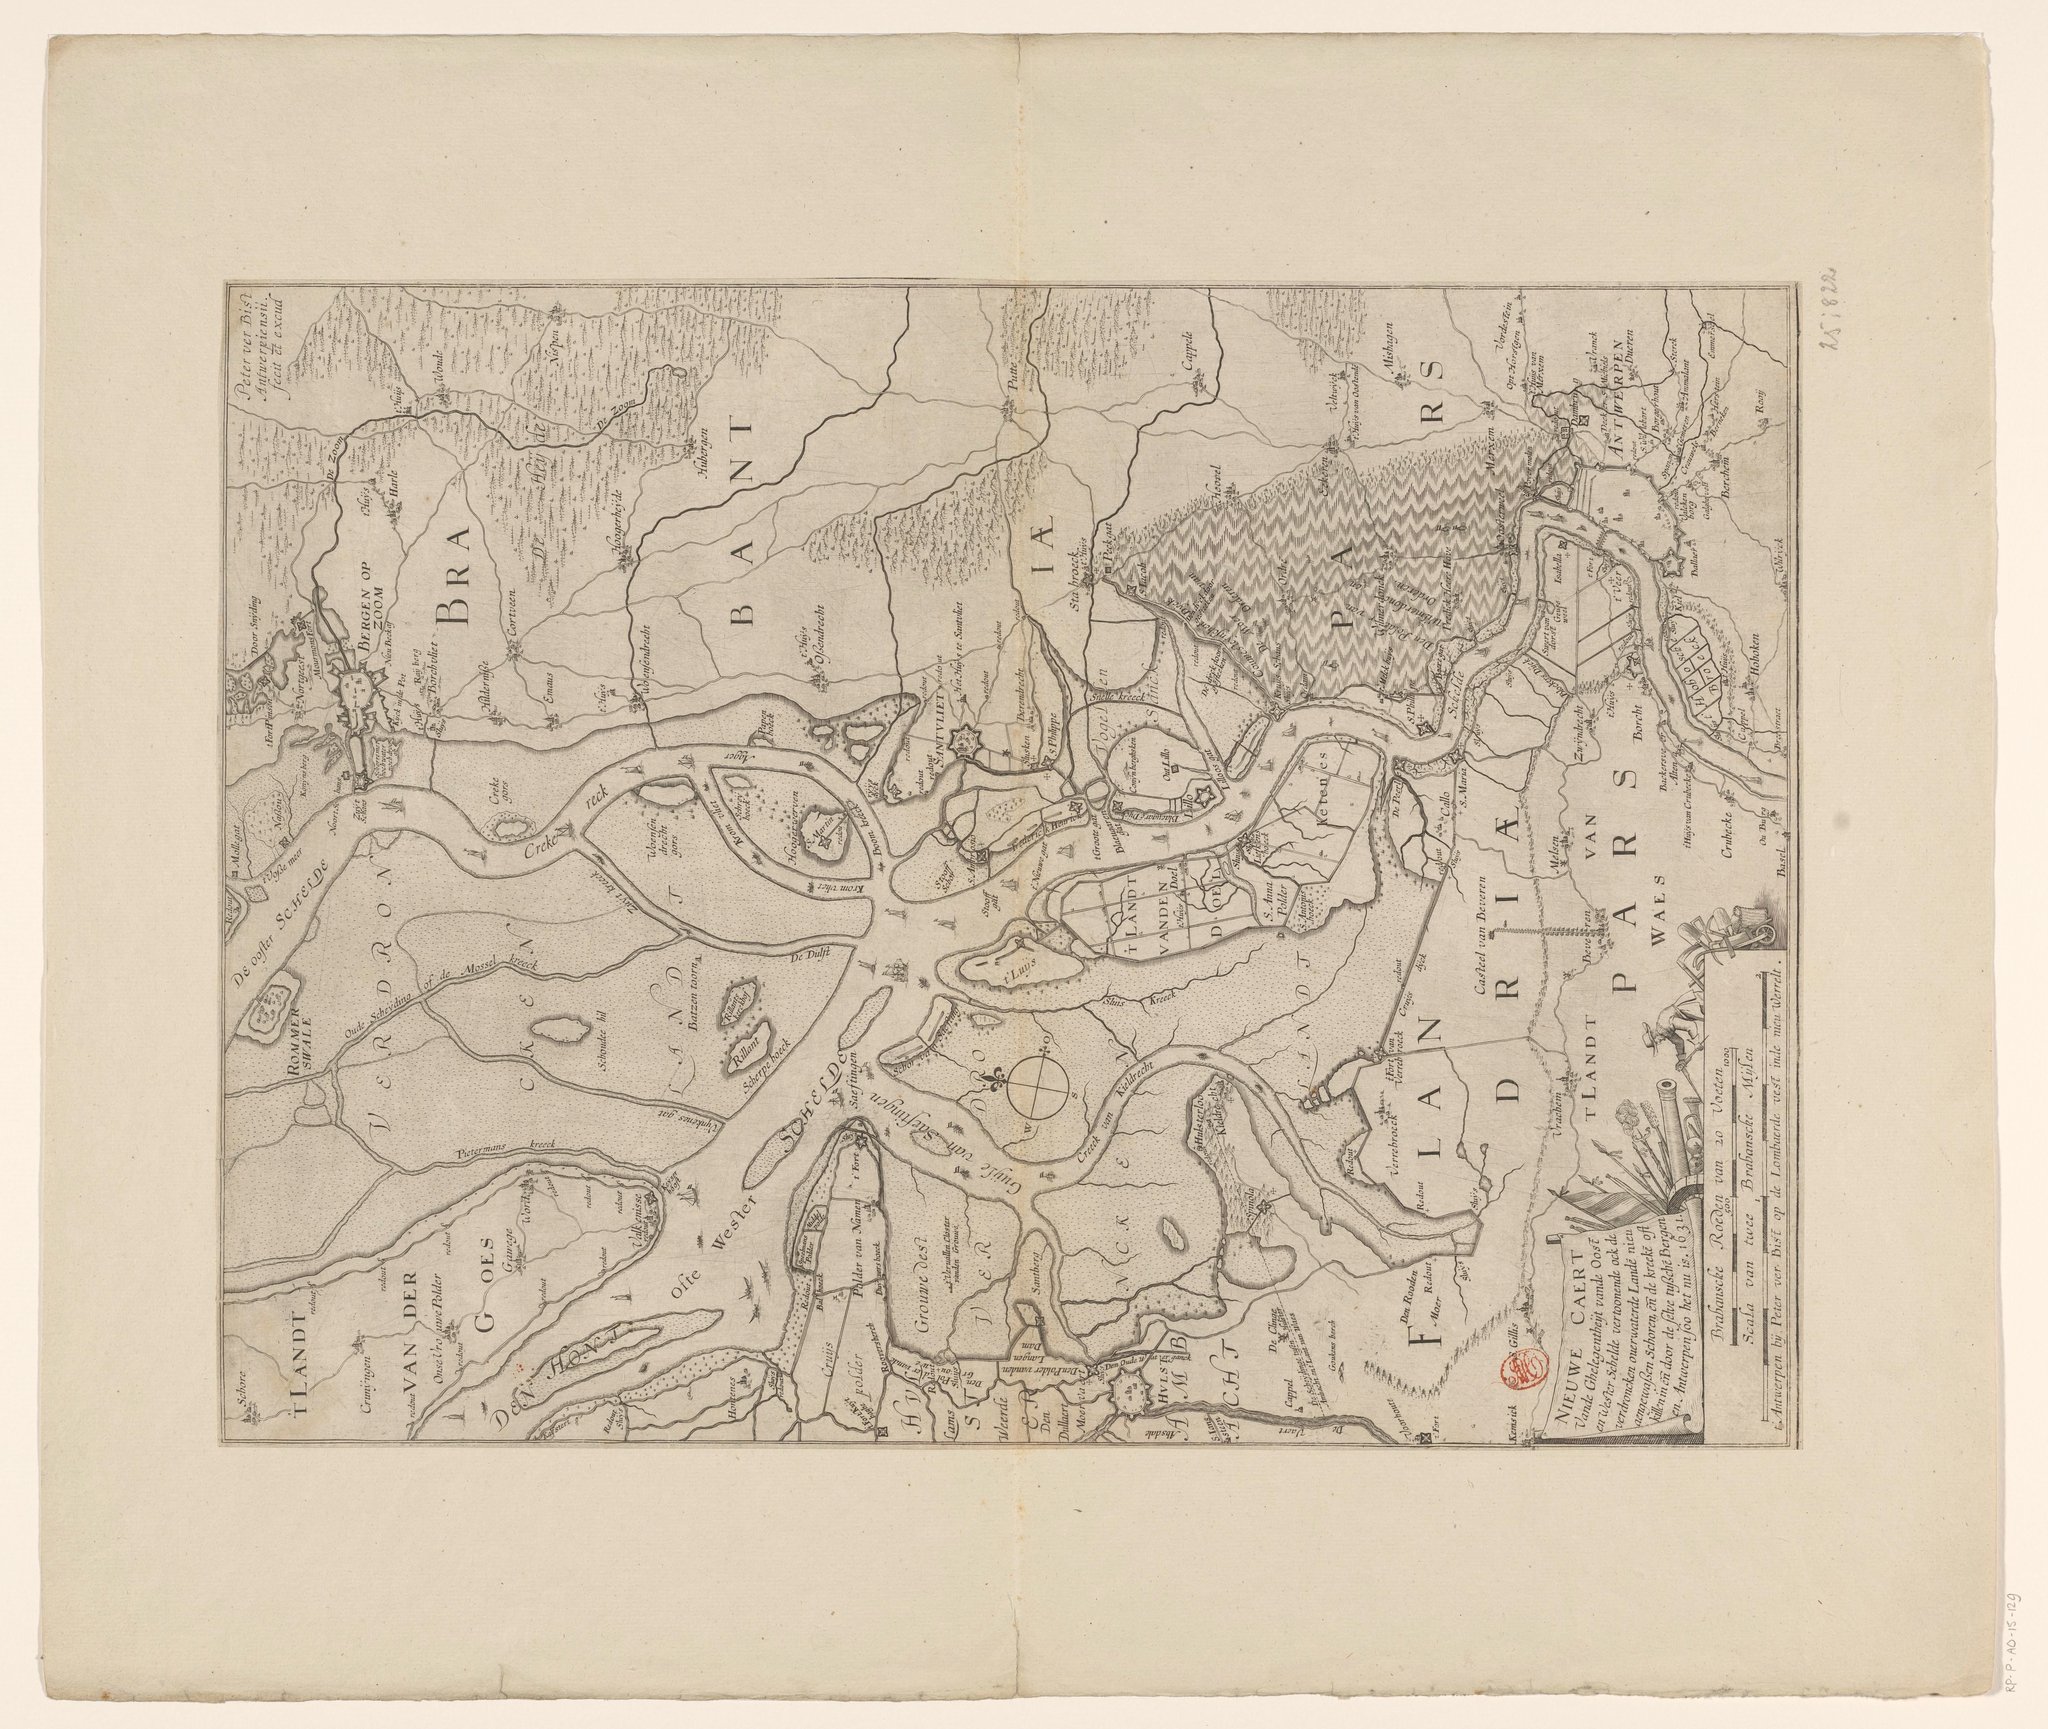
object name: map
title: Nieuwe caert Vande Ghelegentheijt vande Oost en Wester Schelde vertoonende ock de verdroncken overwaterde Lande nieu aengewassen Schoren, en de kreeke oft killen en door selve tussche Bergen en Antwerpen soo het nu is. 1631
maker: pieter verbiest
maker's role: print maker, publisher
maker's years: 1607-1674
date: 1631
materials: paper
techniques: engraving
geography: antwerp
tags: maps of separate countries or regions, zeeland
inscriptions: collector's mark: Lugt 195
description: Kaart van de Ooster- en Westerschelde in 1631. Linksonder een cartouche met de titel en daaronder twee schaalstokken: Brabanscke roeden van 20 voeten; Scala van twee Brabanscke mijlen.